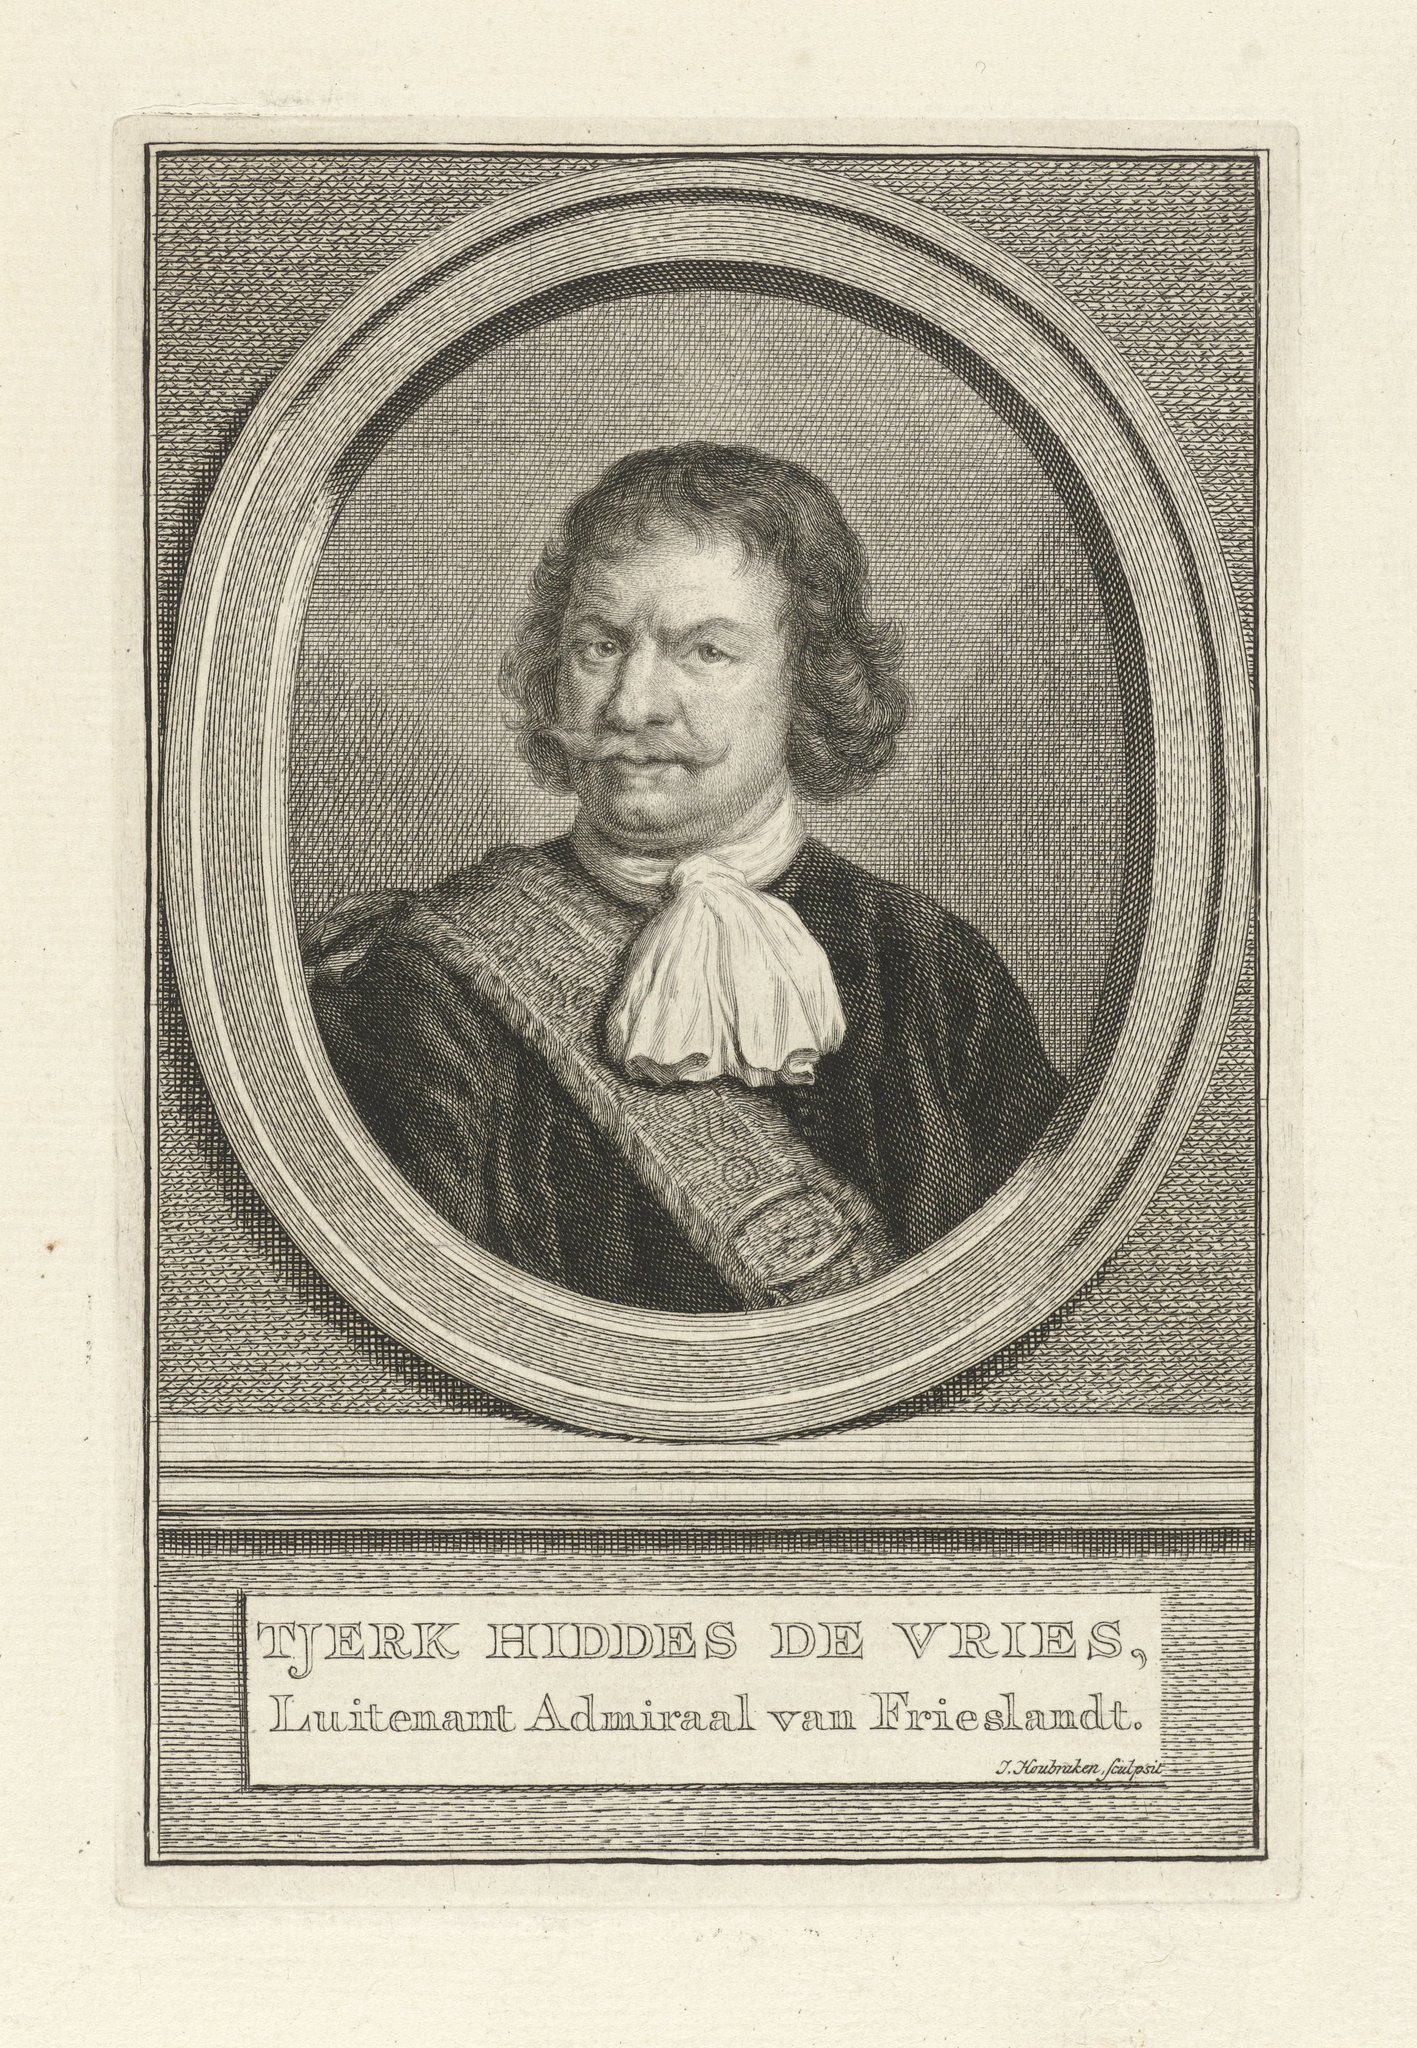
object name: print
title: Tjerk Hiddes de Vries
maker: jacob houbraken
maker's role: draughtsman, print maker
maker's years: 1698-1780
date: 1749-1759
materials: paper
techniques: engraving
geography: amsterdam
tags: sexbierum, tjerck hiddes de vries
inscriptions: collector's mark: Lugt 240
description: Prent oorspronkelijk bedoeld voor: Jan Wagenaar, Vaderlandsche historie, vervattende de geschiedenissen der nu Vereenigde Nederlanden, inzonderheid die van Holland (...), 21 delen. Amsterdam, Isaak Tirion, 1749-59.